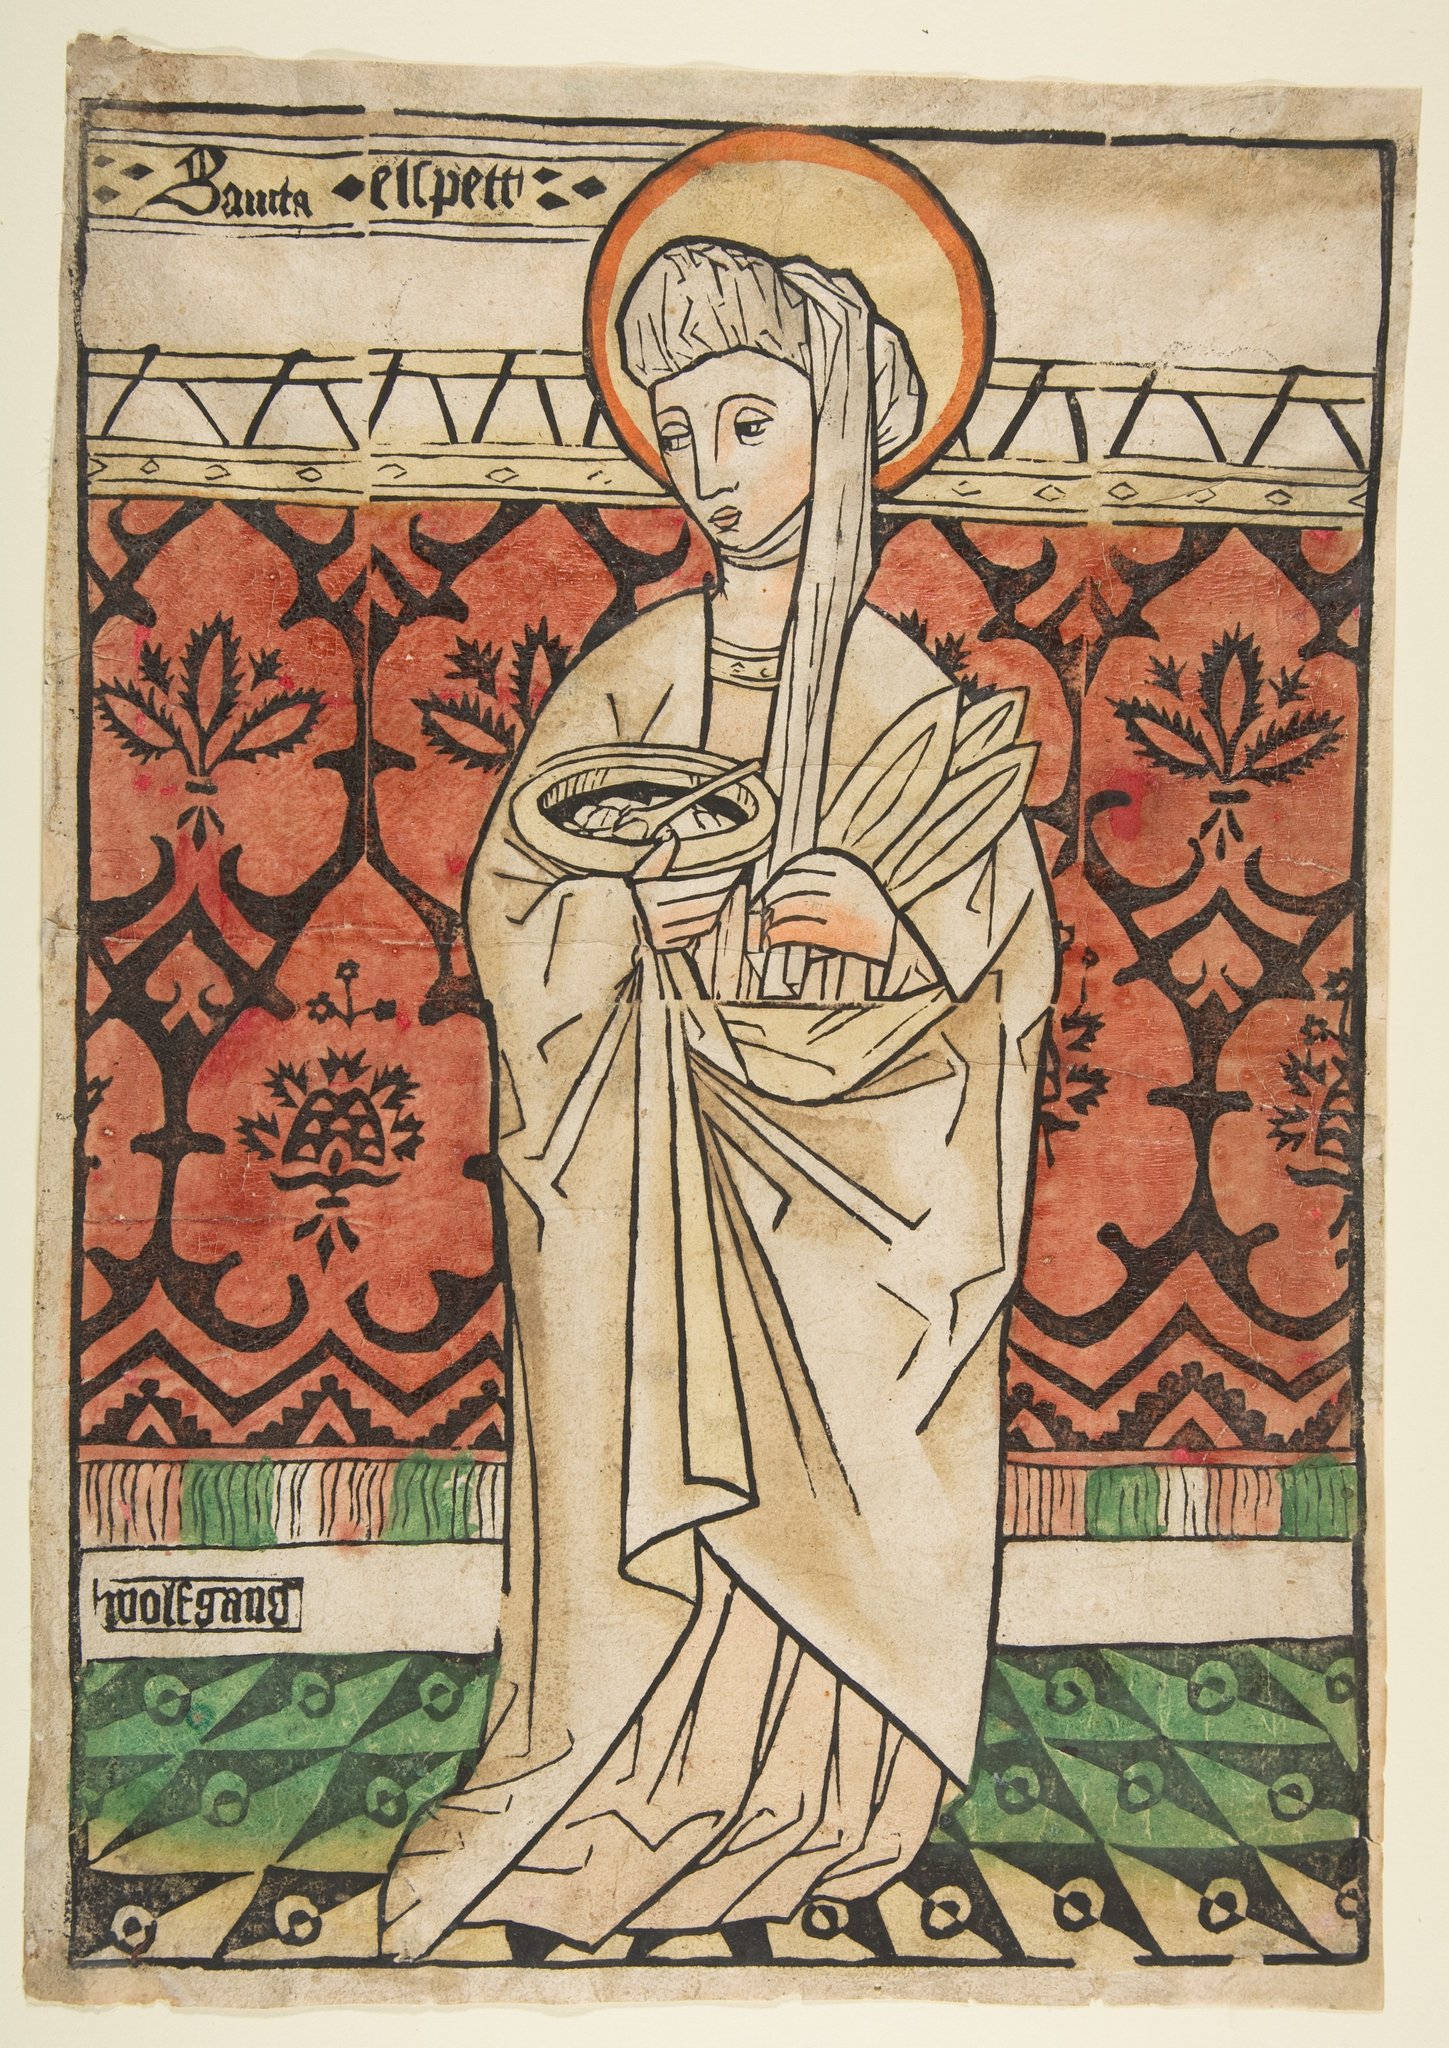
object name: print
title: Saint Elizabeth of Hungary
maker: wolfgang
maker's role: artist and publisher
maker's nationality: german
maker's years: 1450-1500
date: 1470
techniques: hand coloring, woodcut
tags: women,saints